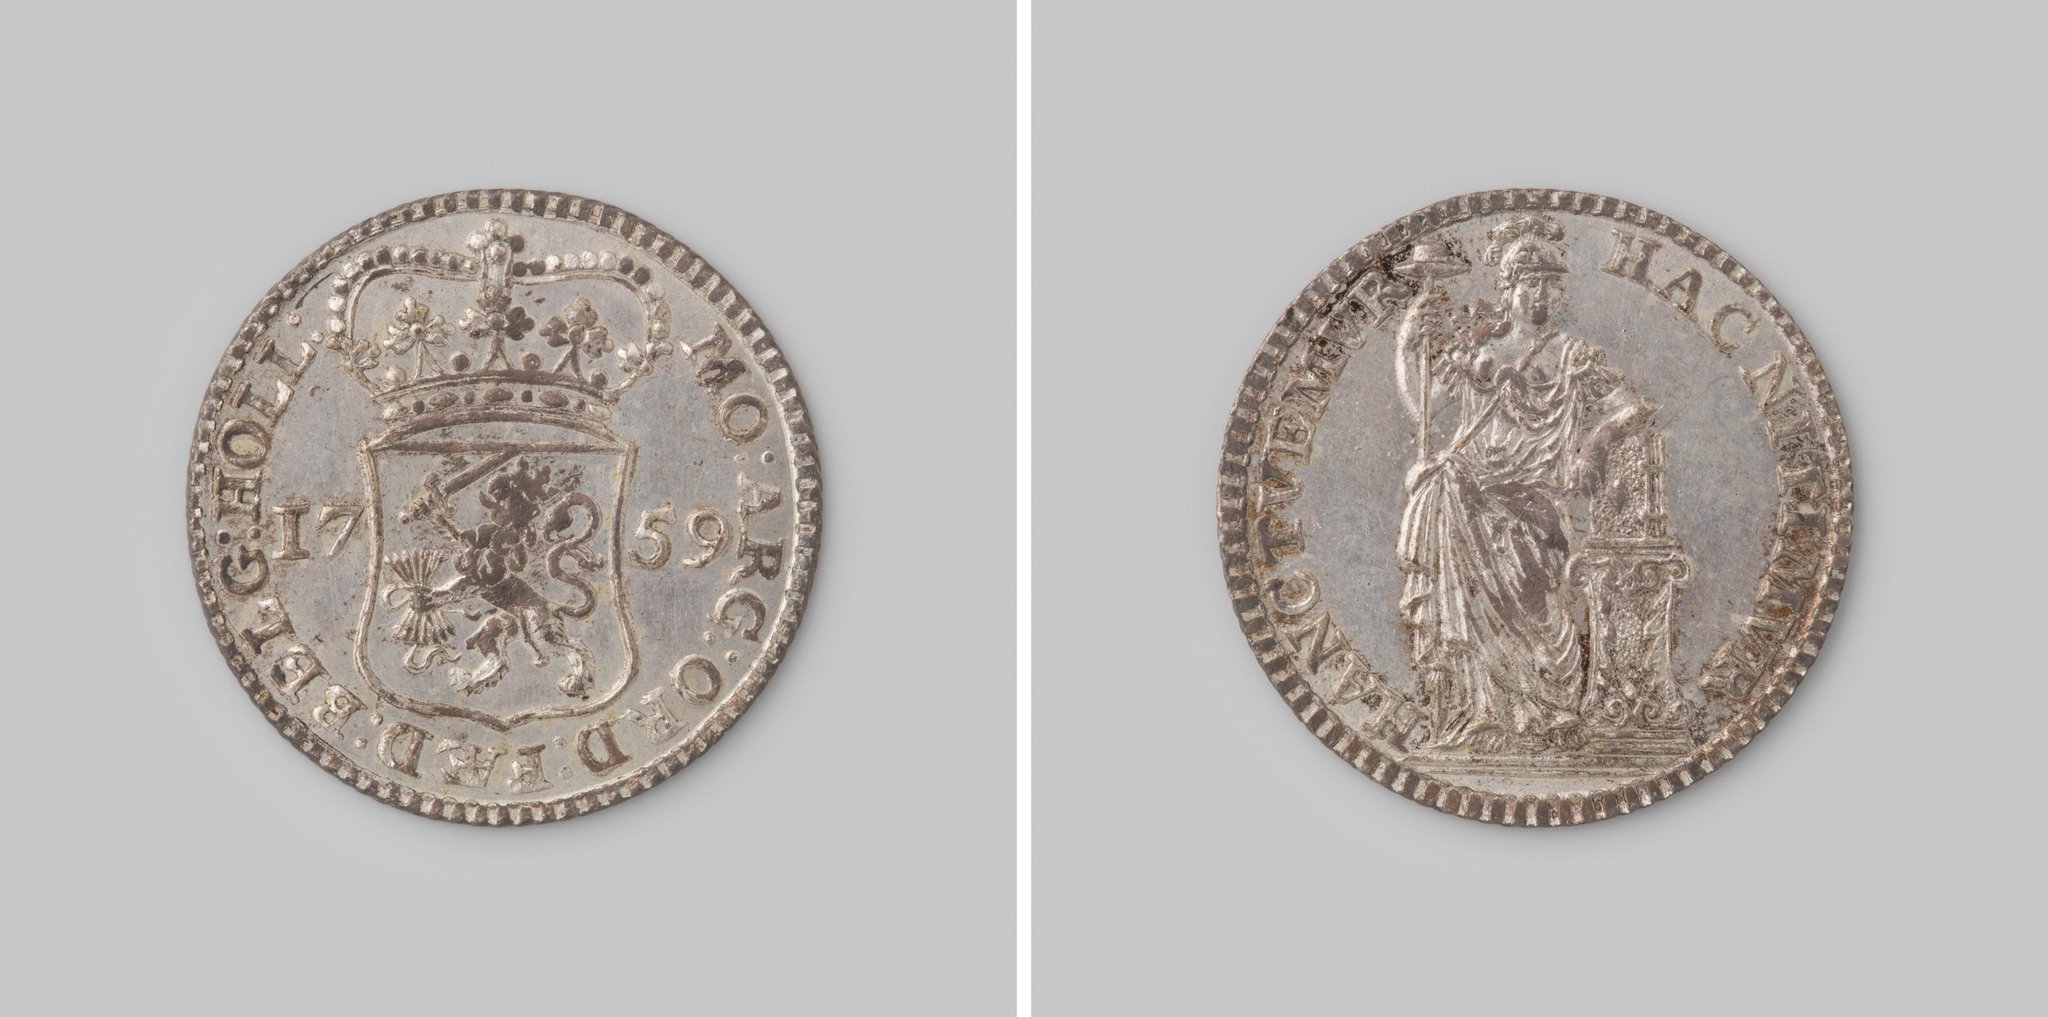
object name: coin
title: Holland, kwart gulden, 1759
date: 1759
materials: silver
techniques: striking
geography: dordrecht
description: Zilveren munt. Voorzijde: tussen jaartal gekroond generaliteitswapenschild. Jaartal boven kroon. Keerzijde: staande Nederlandse maagd met in rechterhand speer, waarop hoed en met linkerhand steunend op altaar, waarop bijbel. Zogenaamde muntmeesterspenning.